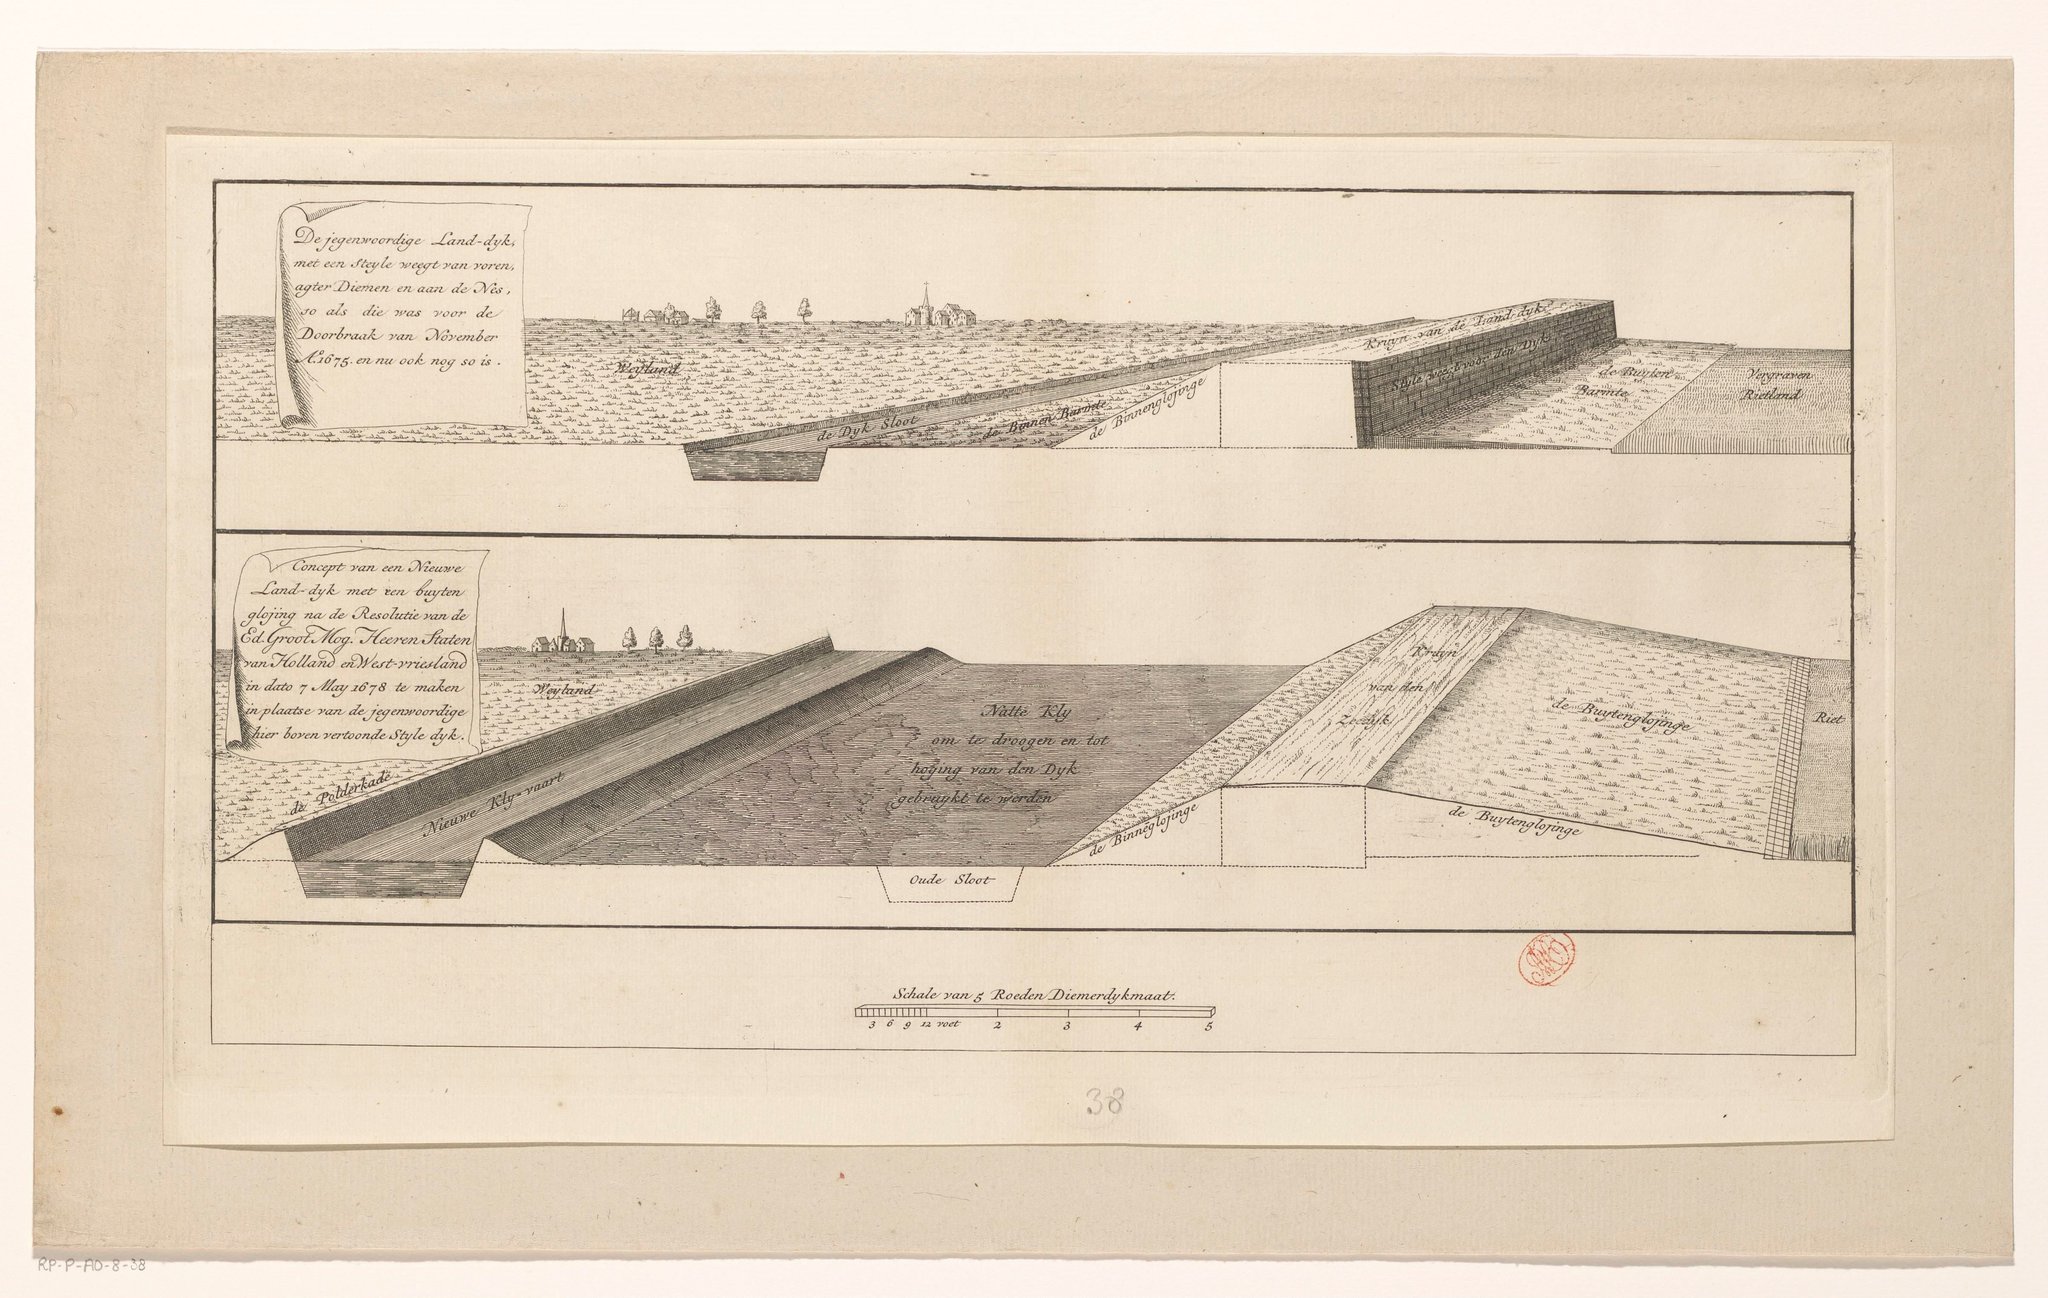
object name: print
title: Concept van een nieuwe land-dyk met een buyten glojing na de resolutie van de Ed. Groot Mog. Heeren Staten van Holland en West-vriesland in dato 7 may 1678 …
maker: coenraad de putter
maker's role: print maker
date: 1729-1737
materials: paper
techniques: engraving, etching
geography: amsterdam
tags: prospect of village, silhouette of village, dikes, levee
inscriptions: collector's mark: Lugt 195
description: Rond 1730 waren de houten palen van de Diemerzeedijk ernstig aangetast door paalworm. In 1737 zouden de houten palen worden vervangen door stenen. Landmeter A.D. Mutsert maakte een aantal tekeningen van de toenmalige Diemerzeedijk en Diemerlanddijk en mogelijke verbeteringen, waarvan ook prenten zijn gemaakt. De huidige prent is daar een van. Zie ook RP-P-AO-8-39 en RP-P-AO-8-40.